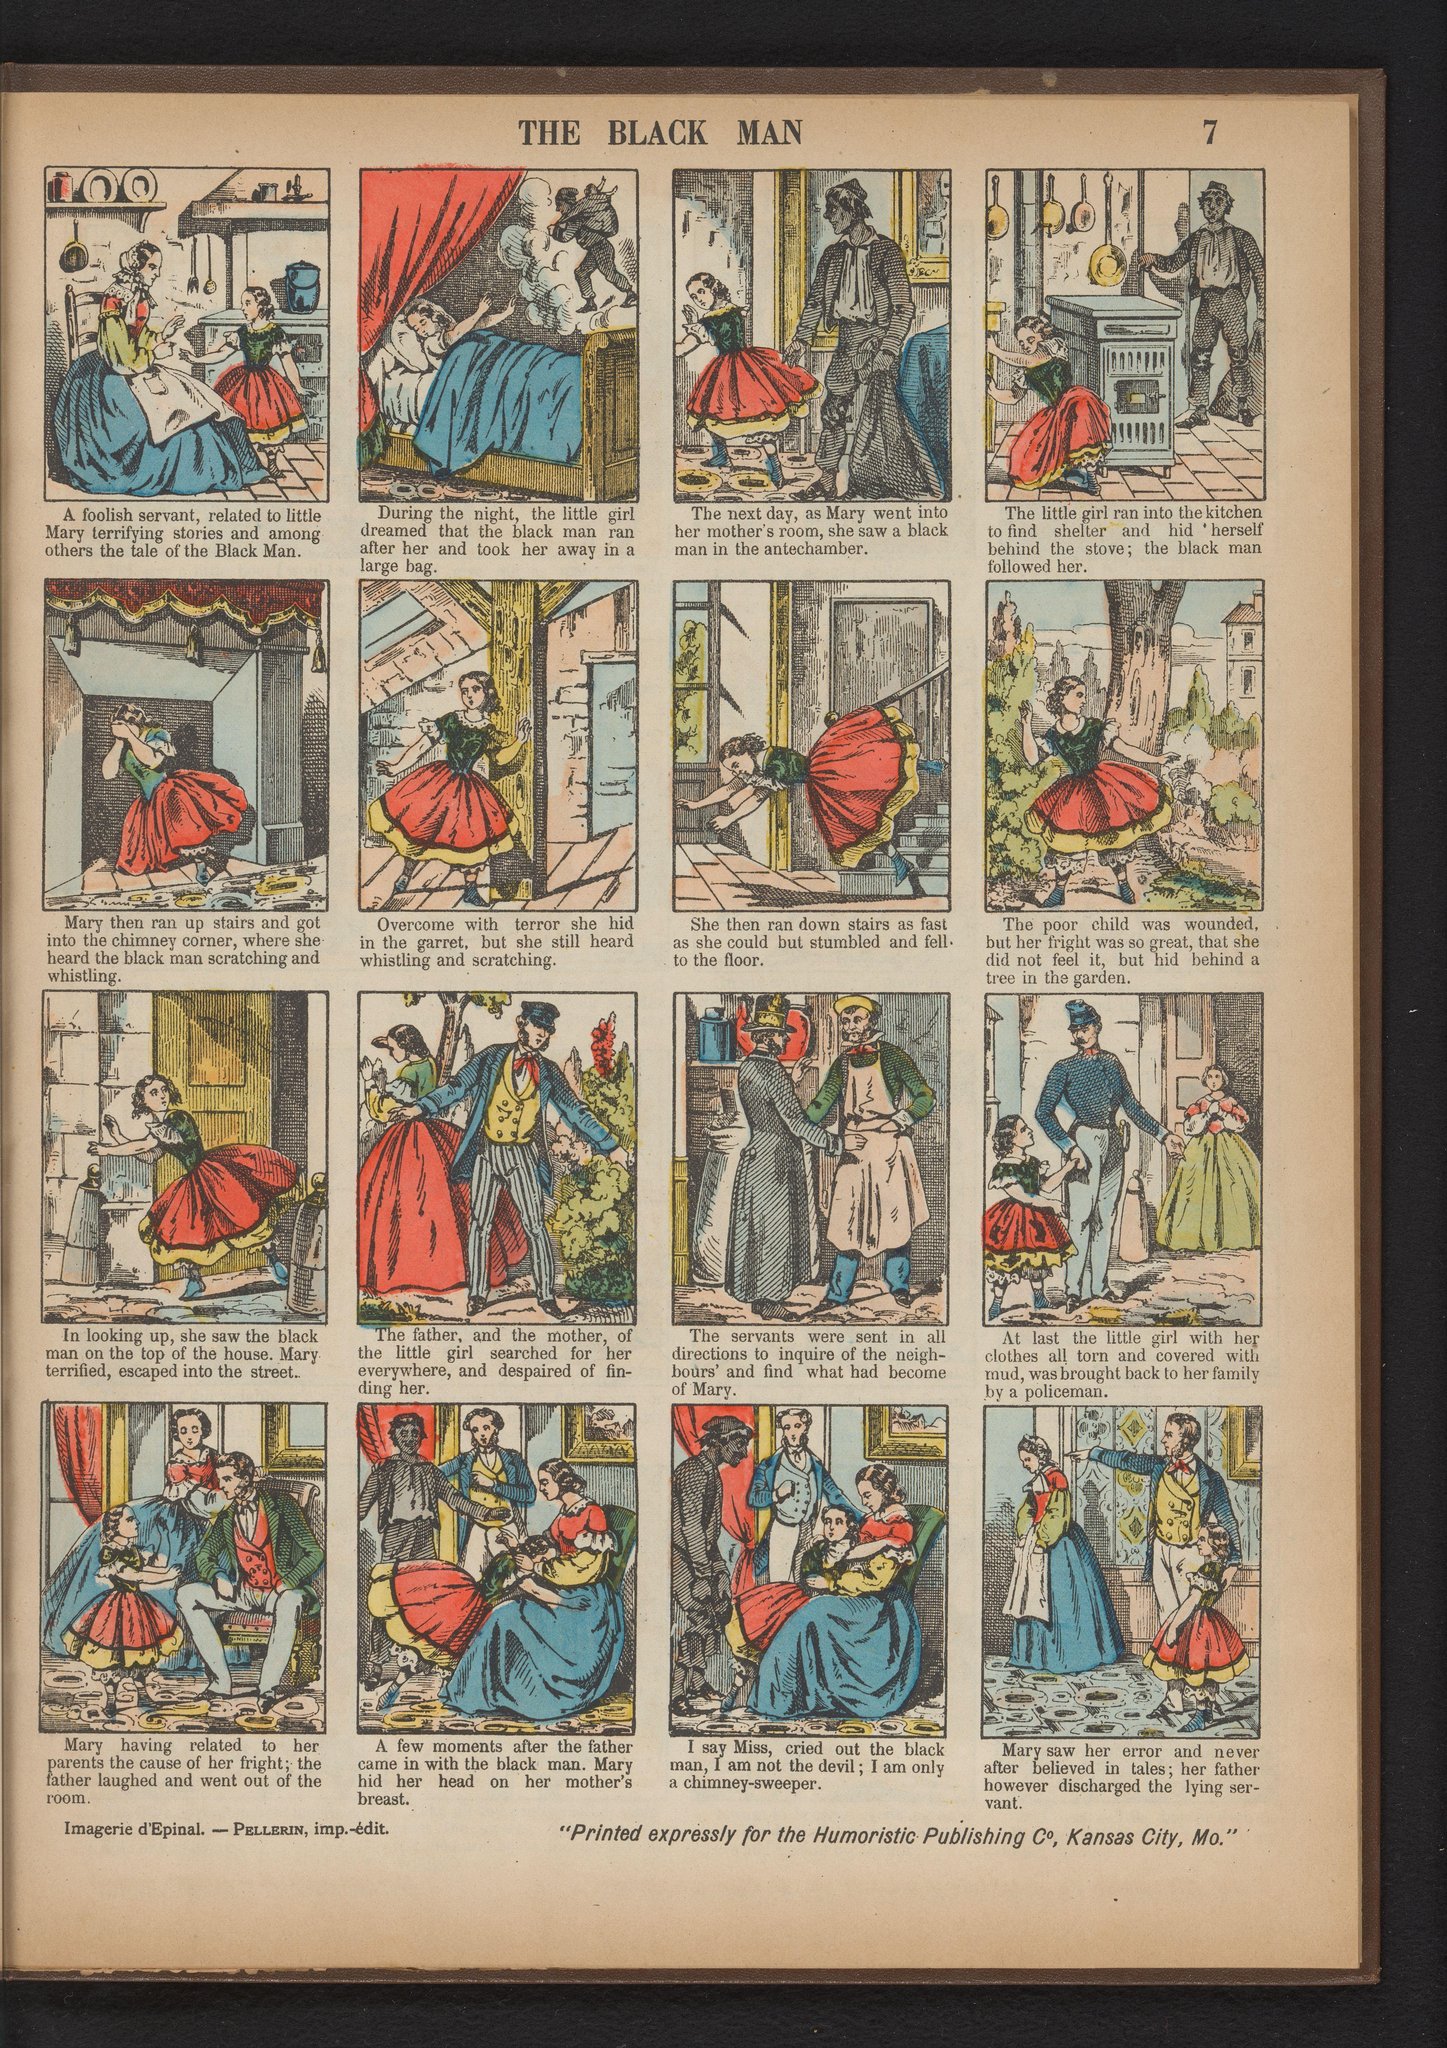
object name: popular print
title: Contes des fées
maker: Anonymous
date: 1893-1894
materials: paper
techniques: colour, letterpress printing, lithograph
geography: epinal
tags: alarm, fright; 'spavento', 'terrore' (ripa), handicrafts ~ maintenance and repair (with name of trade or profession)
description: Blad met zestien voorstellingen over een meisje dat schrikt van de schoorsteenveger. Onder elke voorstelling een onderschrift in het Engels. Deze prent maakt deel uit van een album.